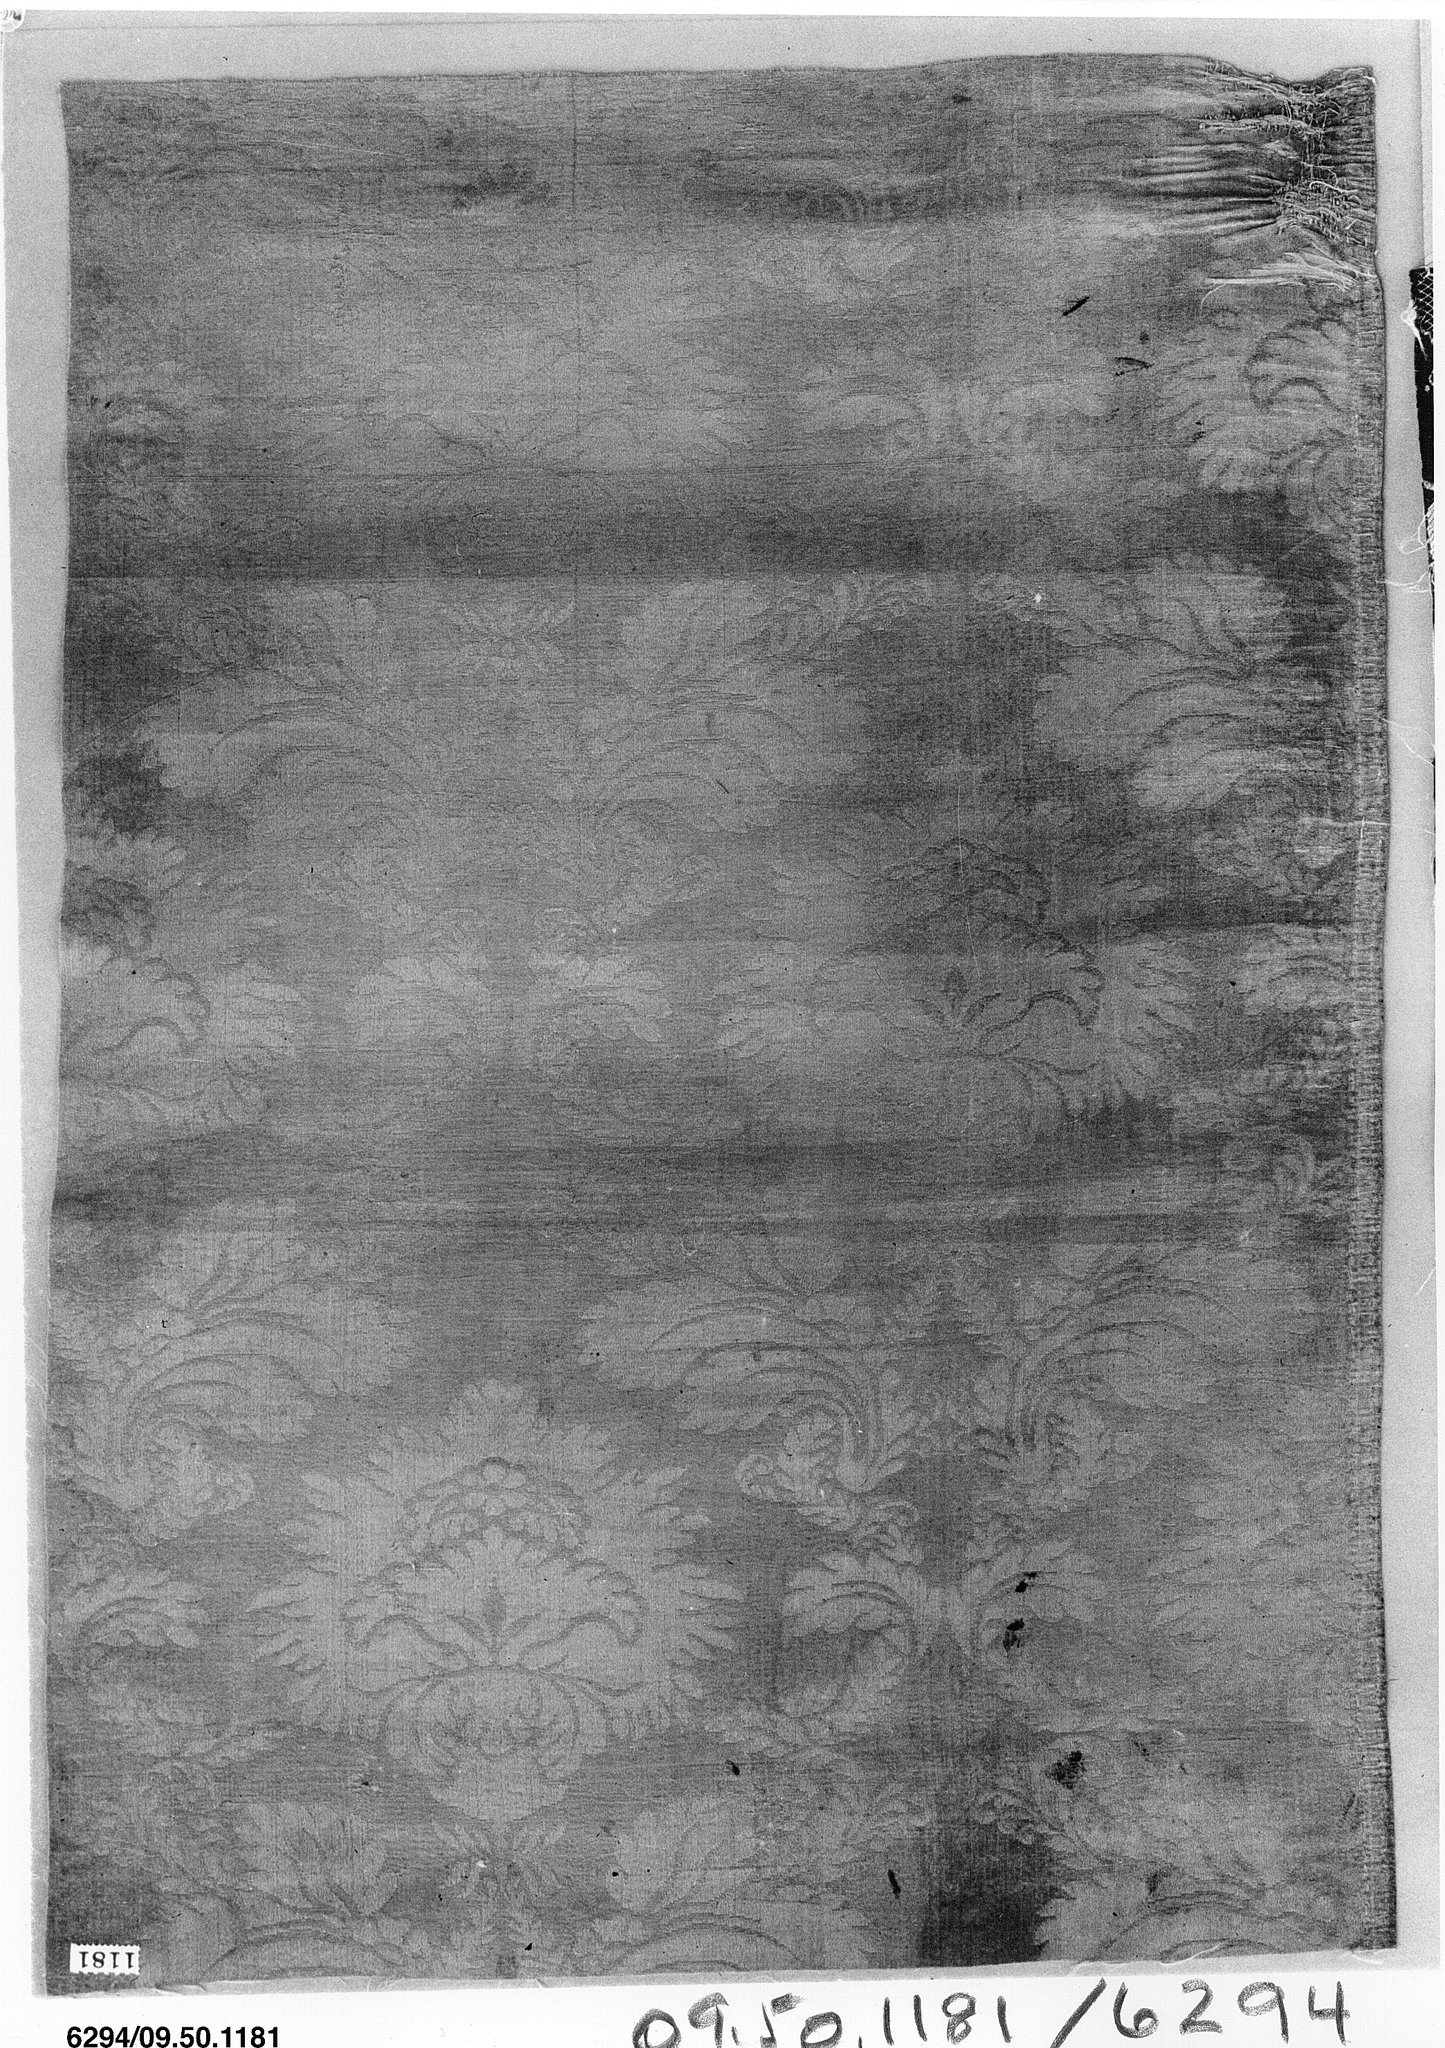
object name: piece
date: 1701-1733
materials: silk